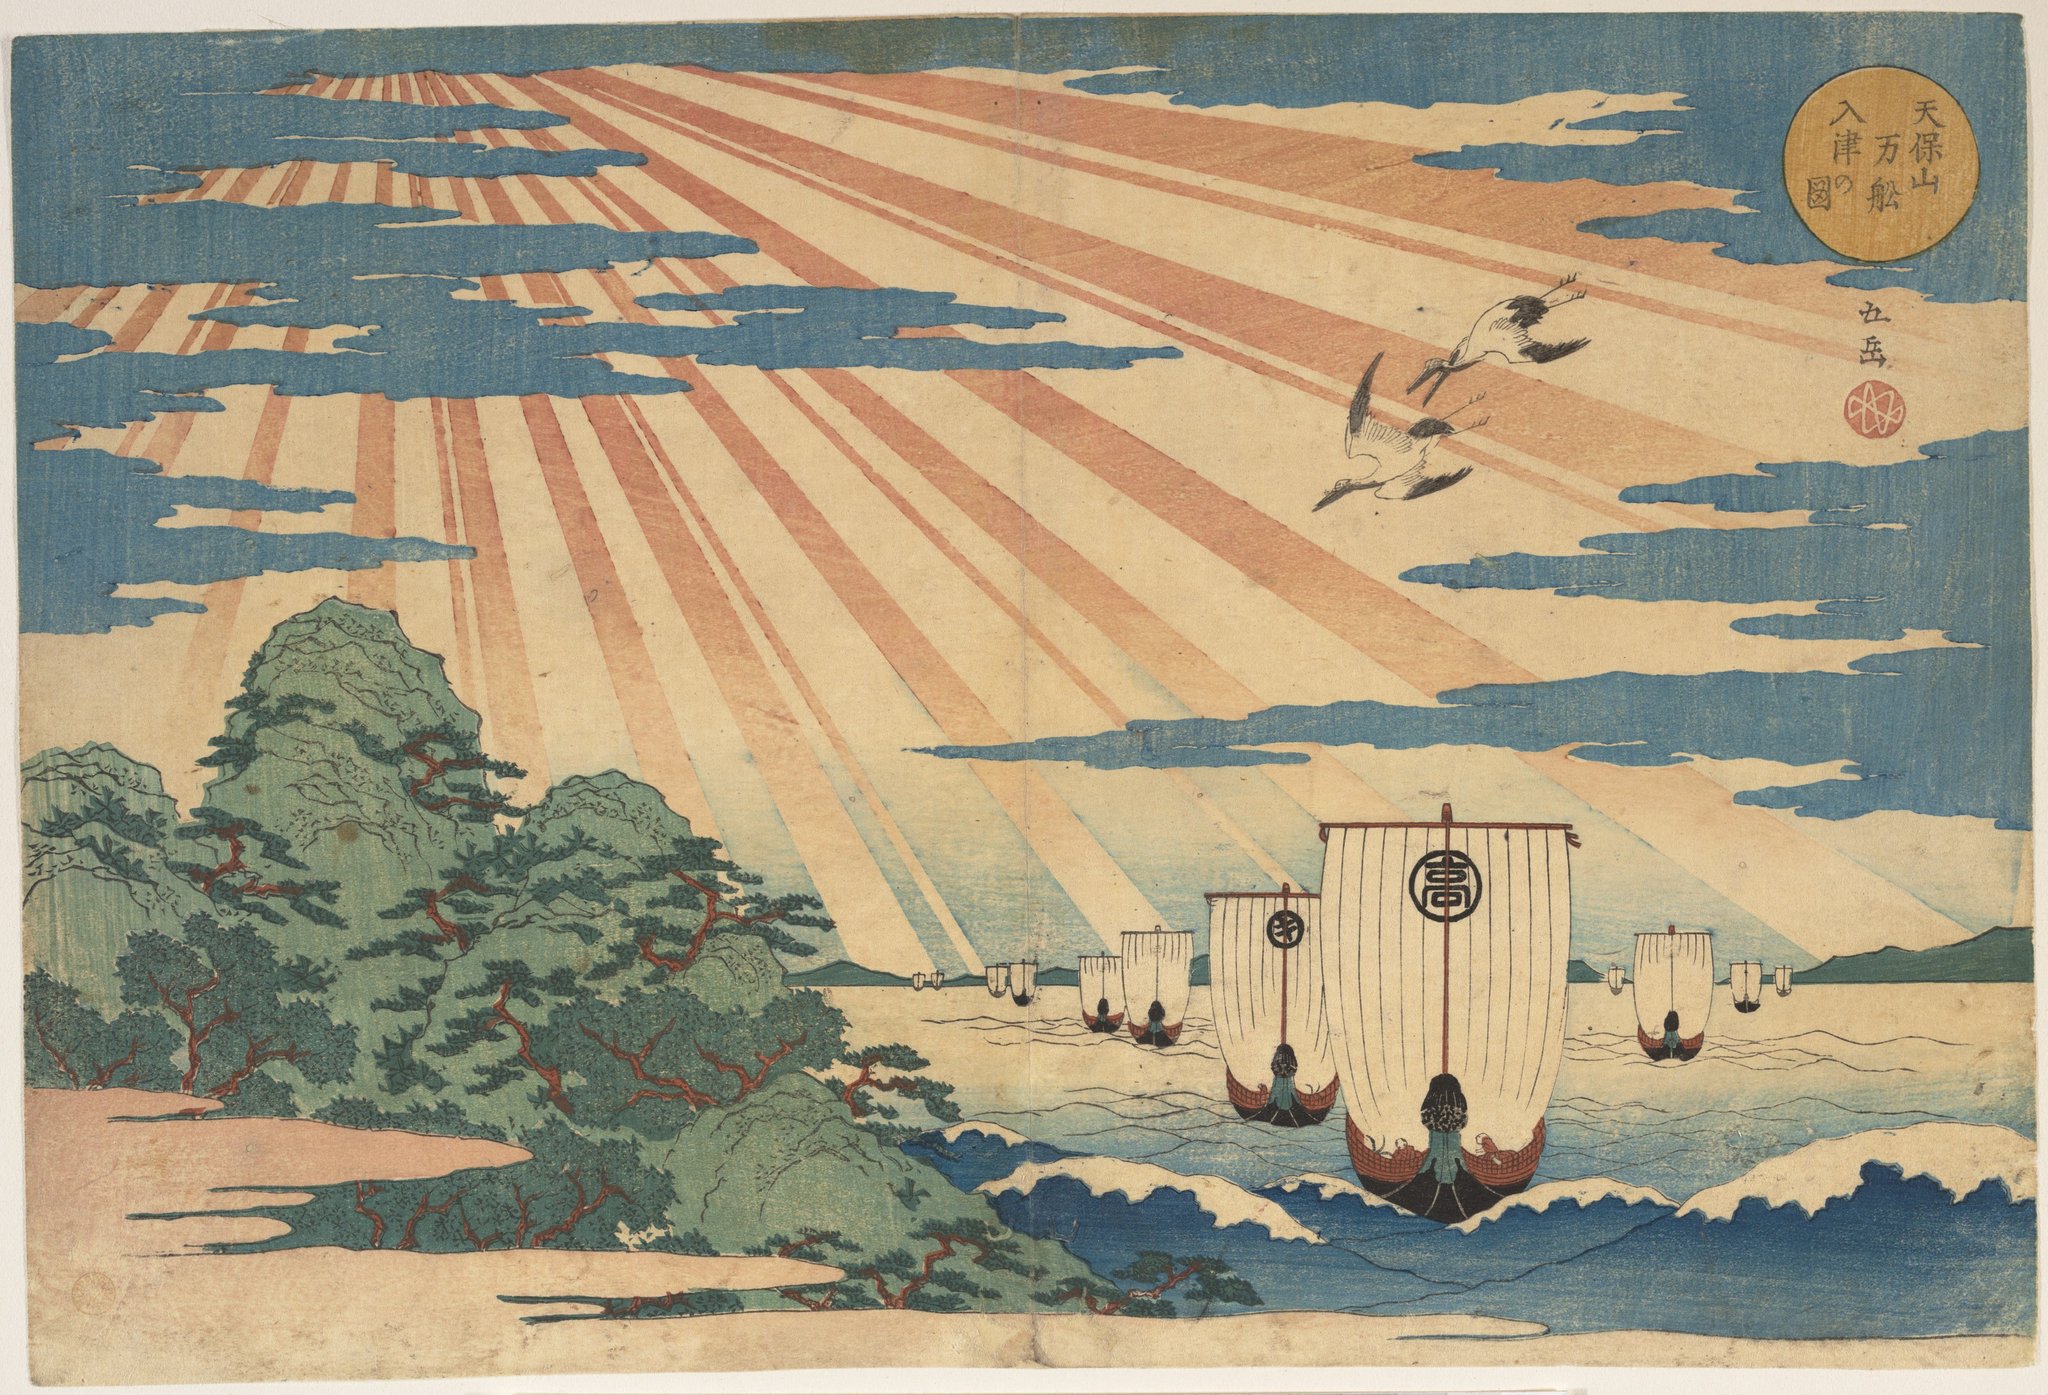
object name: print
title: Tempozan Man-sen Nu-shin no Zu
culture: japanese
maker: yashima gakutei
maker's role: artist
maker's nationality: japanese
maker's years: 1786-1868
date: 1838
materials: ink, paper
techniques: woodblock print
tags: cranes,landscapes,boats